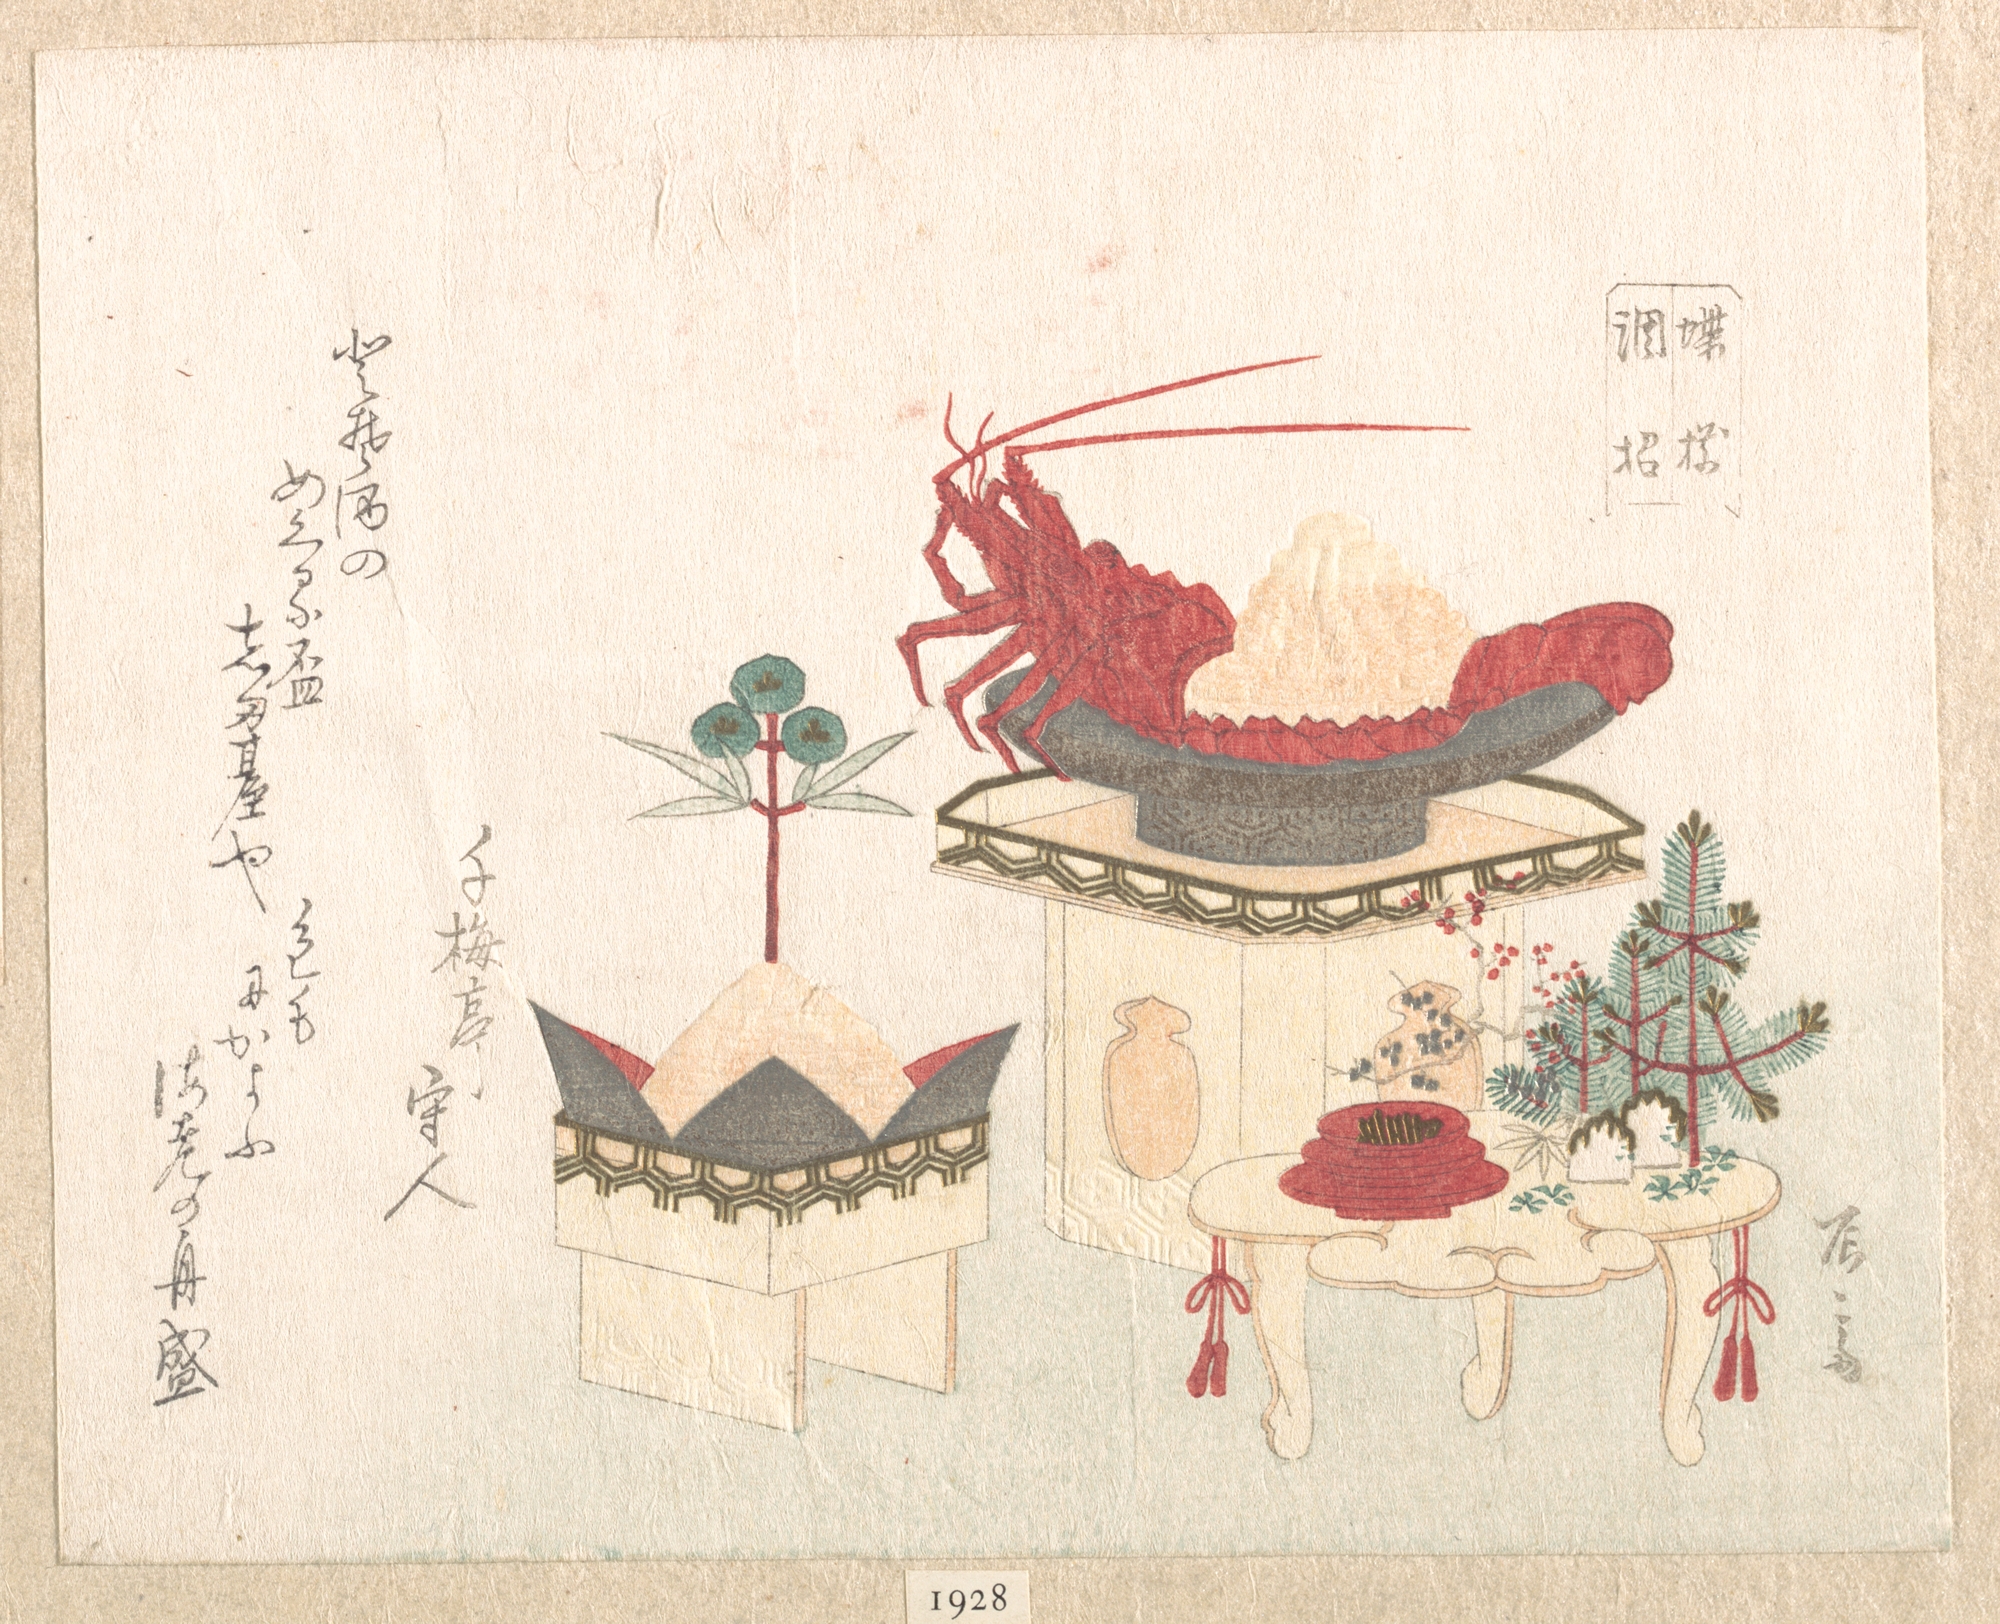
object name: print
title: Decorations for the New Year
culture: japanese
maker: ryūryūkyo shinsai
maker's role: artist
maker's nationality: japanese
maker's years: 1799-1823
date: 1799-1823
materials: ink, paper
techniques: surimono, woodblock print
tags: lobsters,flowers